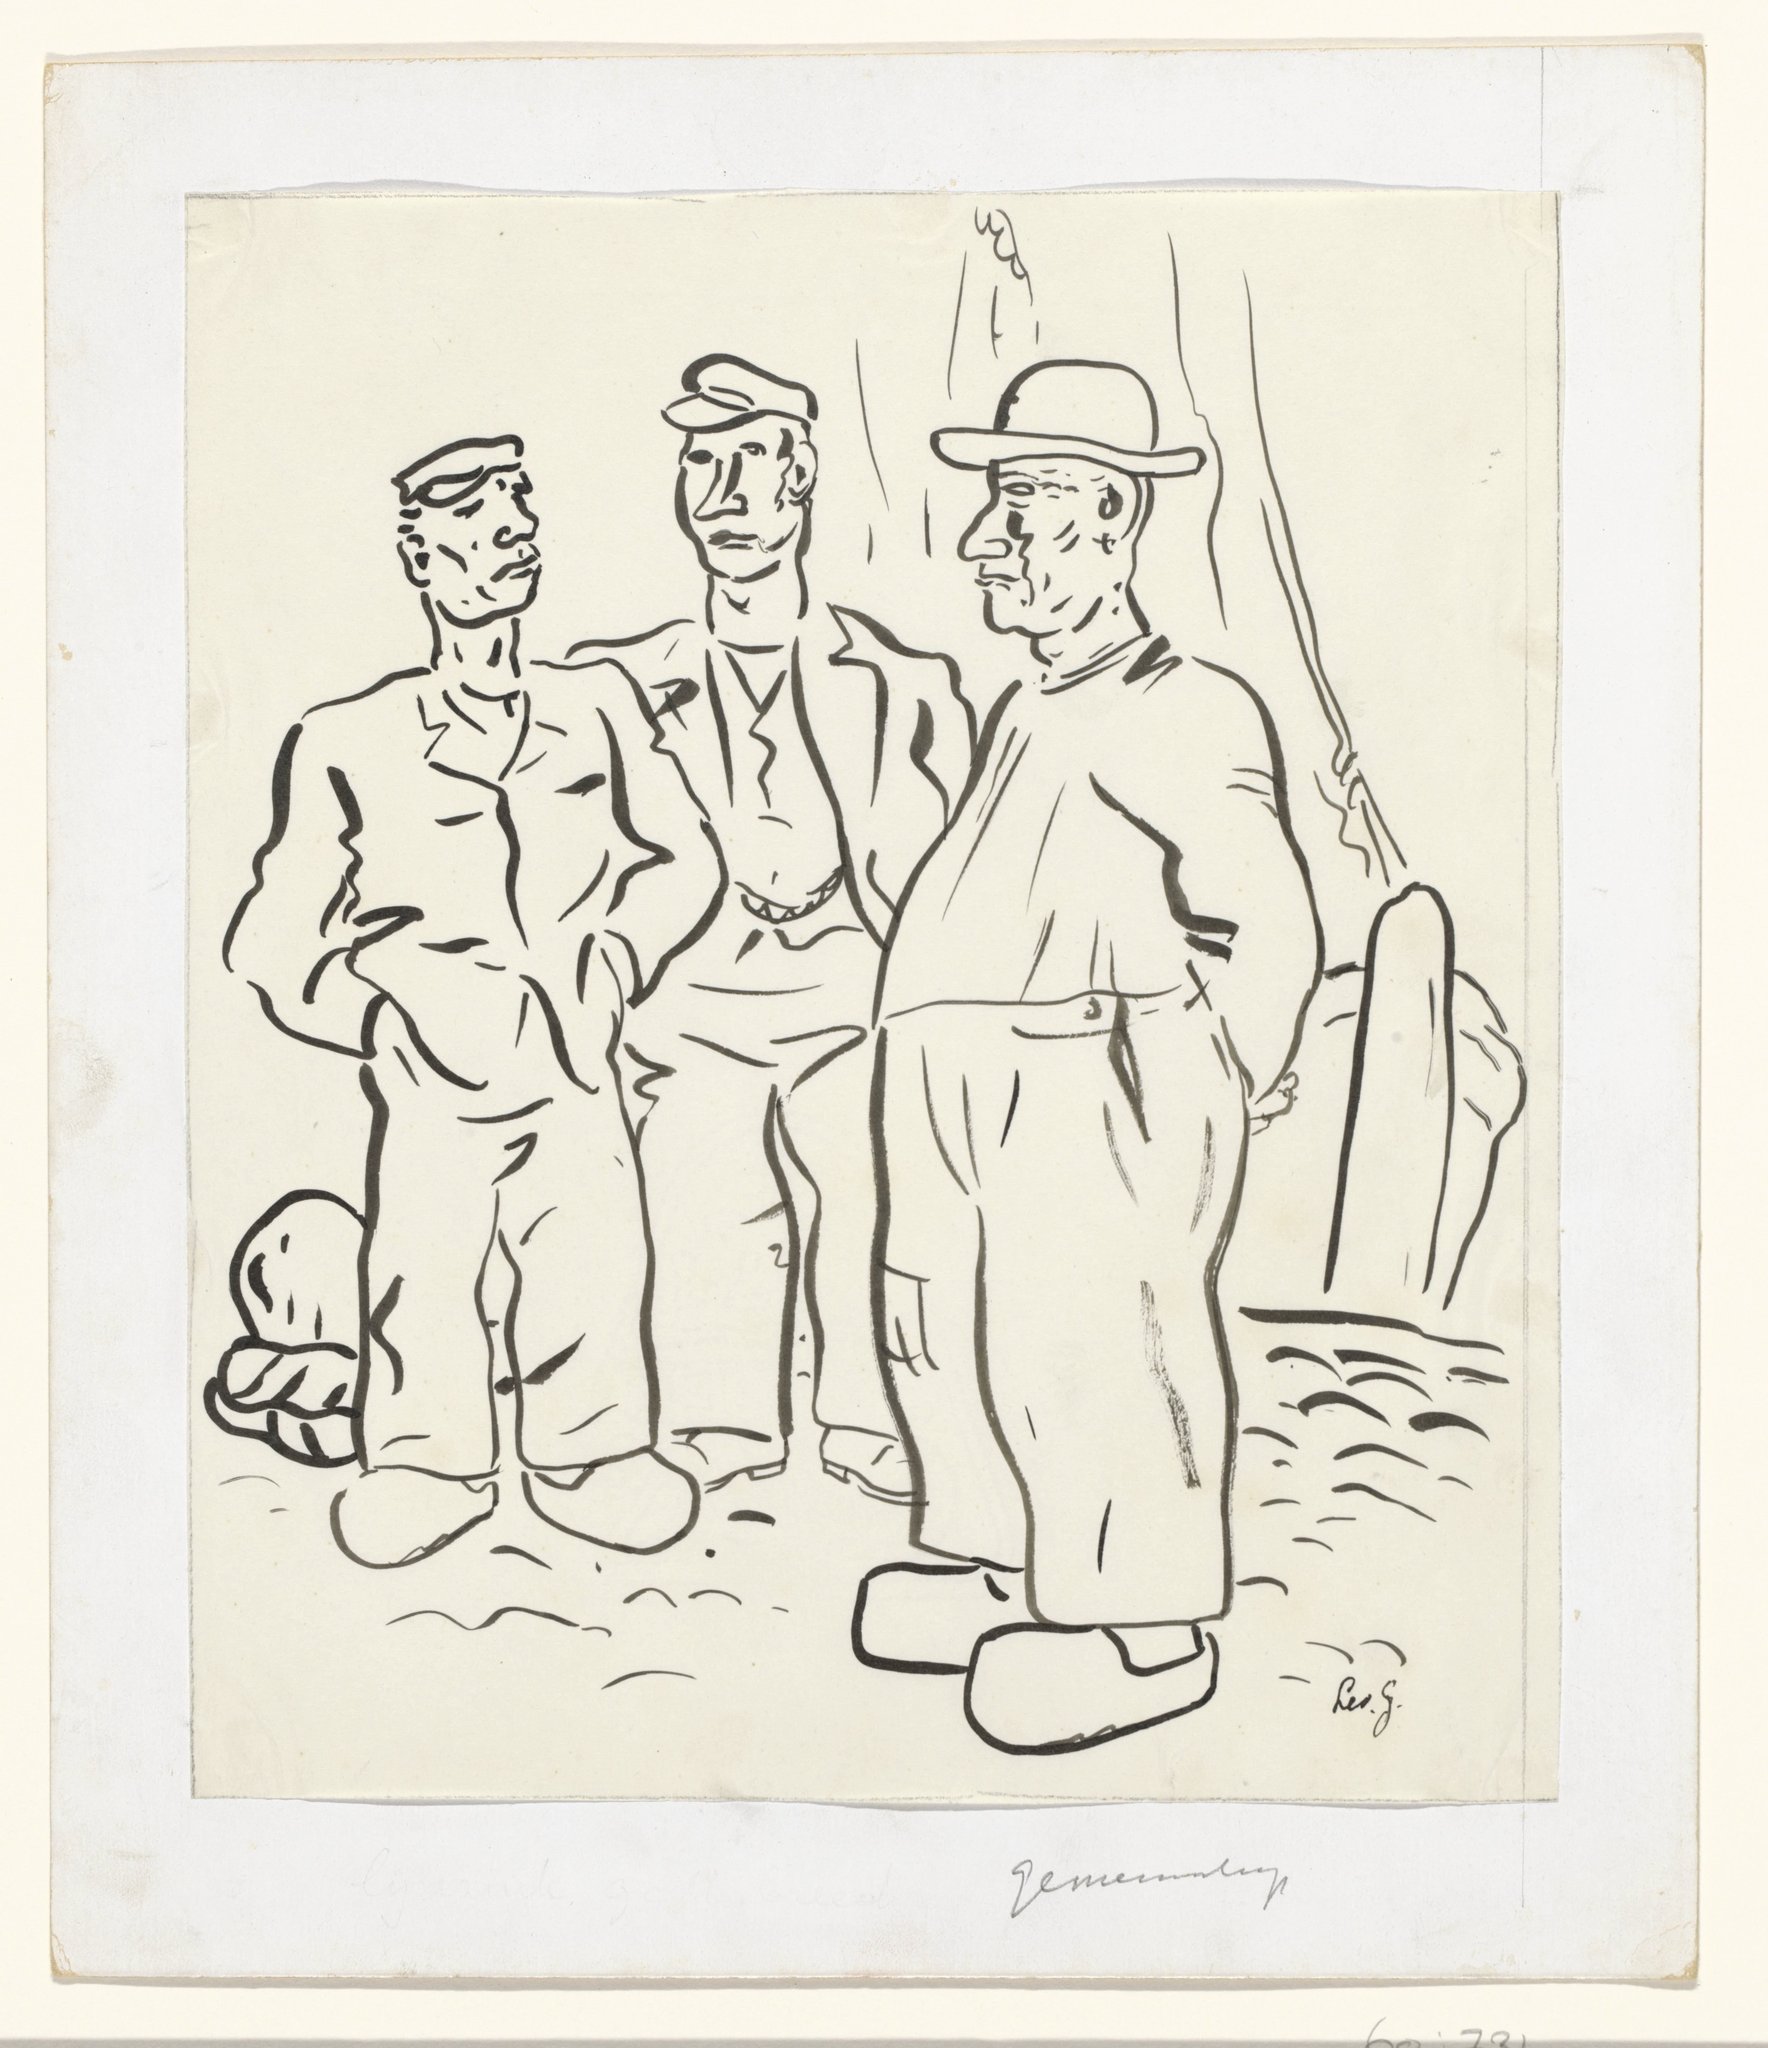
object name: drawing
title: Drie vissers in de haven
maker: leo gestel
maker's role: draughtsman, print maker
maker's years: 1881-1941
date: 1925-1941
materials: ink, paper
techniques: brush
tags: fisherman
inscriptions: collector's mark: Lugt 2228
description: Ontwerp voor een illustratie voor: De Gemeenschap, uitgegeven tussen 1925-1941.